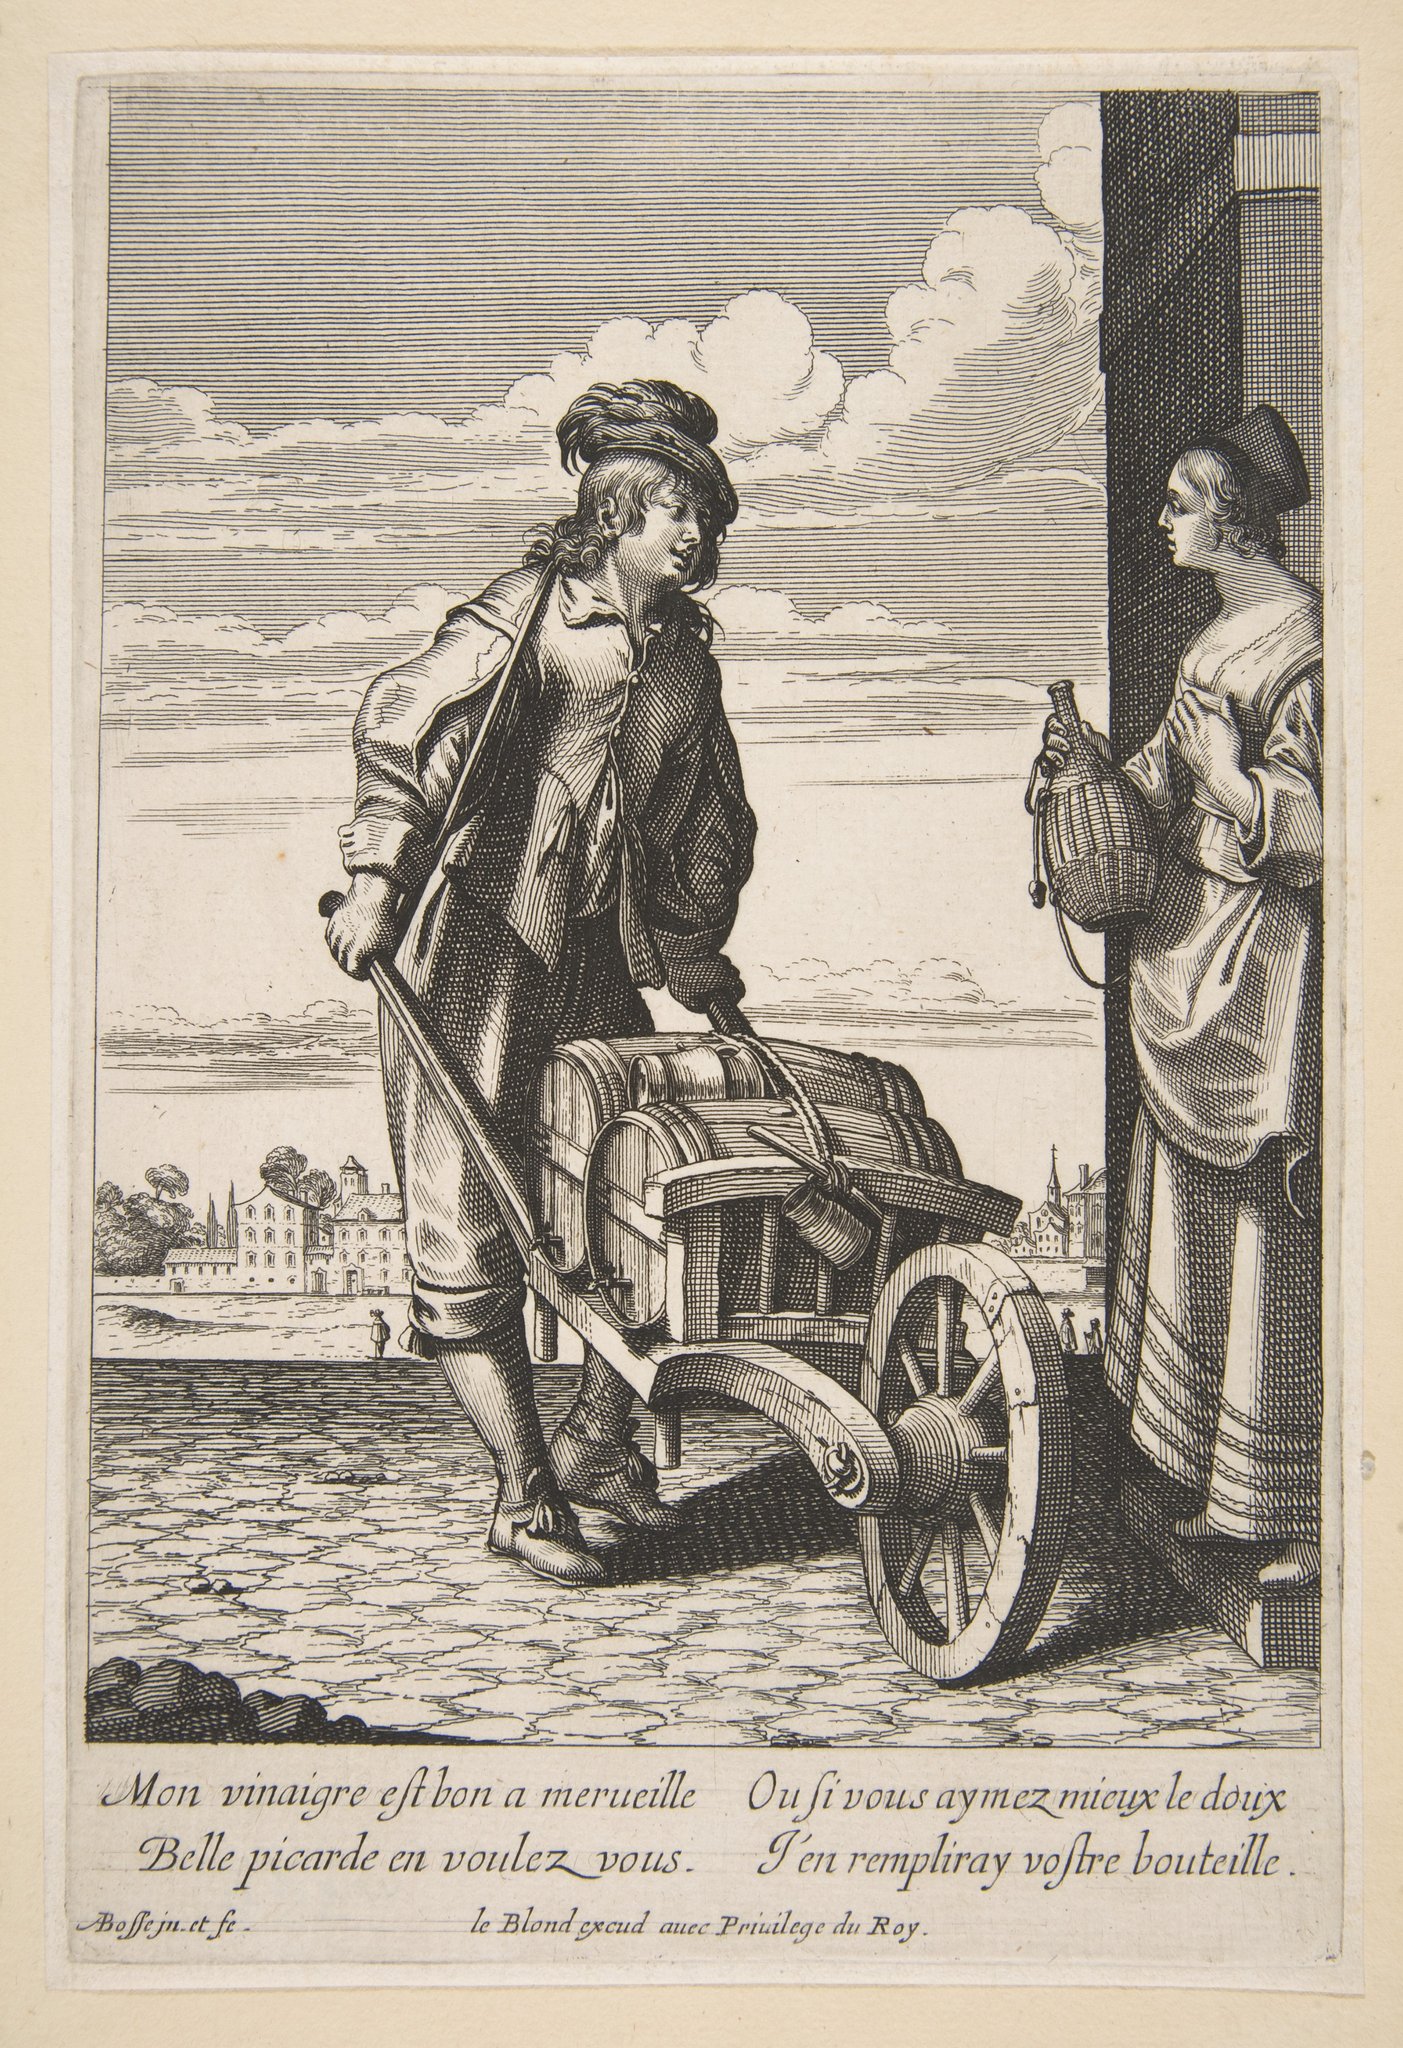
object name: print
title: The Vinegar Merchant, plate 8 from "Cries of Paris" (Les Cris de Paris)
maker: abraham bosse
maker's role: artist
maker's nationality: french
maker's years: 1602-1676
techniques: etching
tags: men,women,merchants